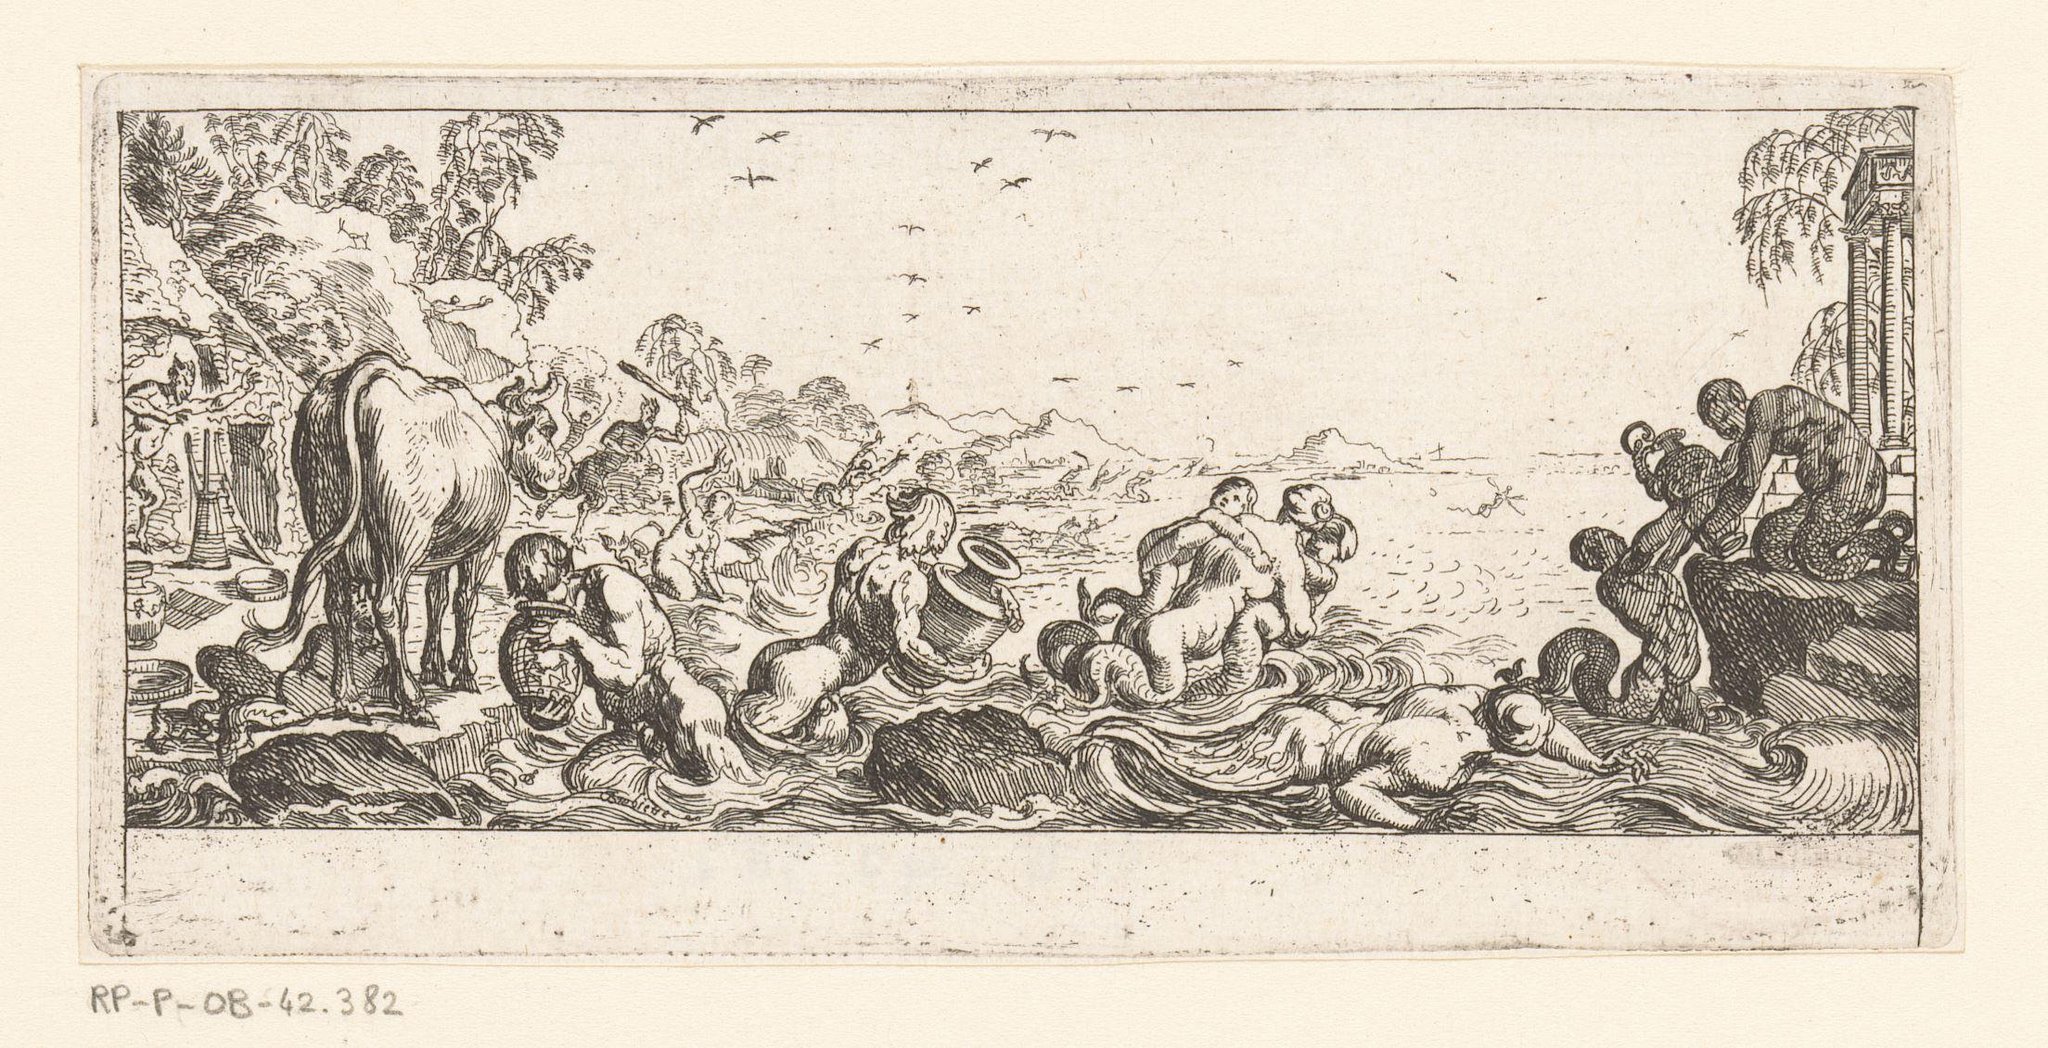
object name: print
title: Nereïden en tritons met urnen aan een kust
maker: pierre brebiette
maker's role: draughtsman, print maker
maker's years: 1598-1650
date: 1608-1650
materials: paper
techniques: etching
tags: triton(s), nereids, daughters of nereus; sea-nymphs, urn, coast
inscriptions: collector's mark: Lugt 240